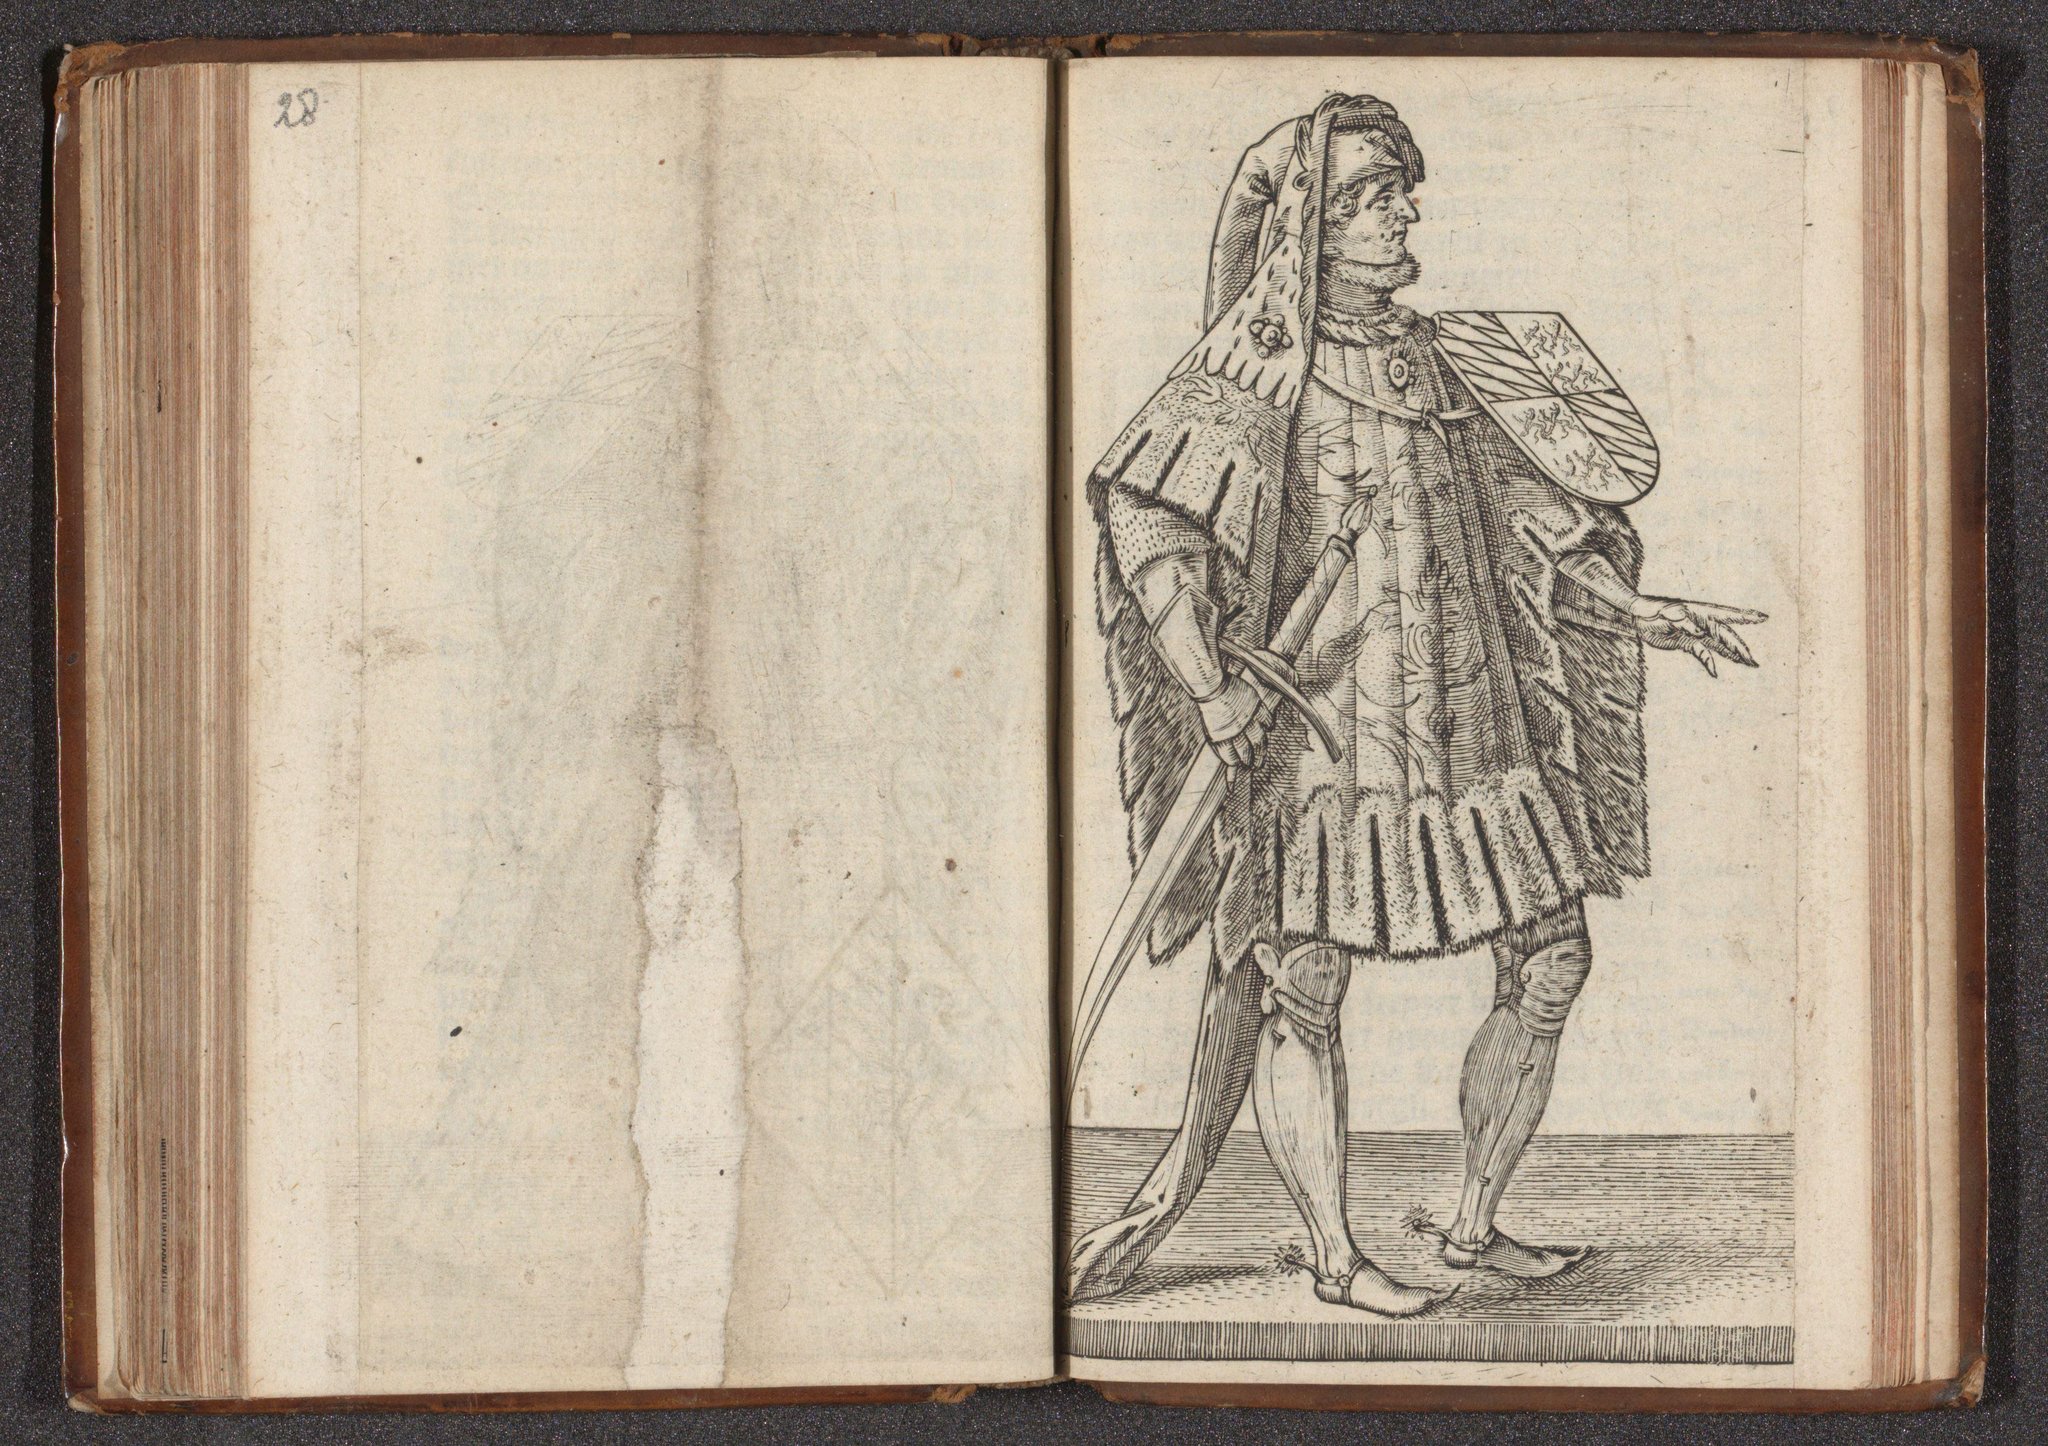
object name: print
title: Graven en gravinnen van Holland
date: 1586-1587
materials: paper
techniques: engraving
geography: haarlem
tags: jan van beieren, historical persons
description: Graaf Jan van Beieren, ten voeten uit en naar rechts gekeerd, met zwaard. Zijn wapenschild heeft vier kwartieren: twee met vier klimmende leeuwen en twee met diagonalen. De prent maakt deel uit van een boek met beschrijvingen en voorstellingen van de graven van Holland, Zeeland en Friesland.